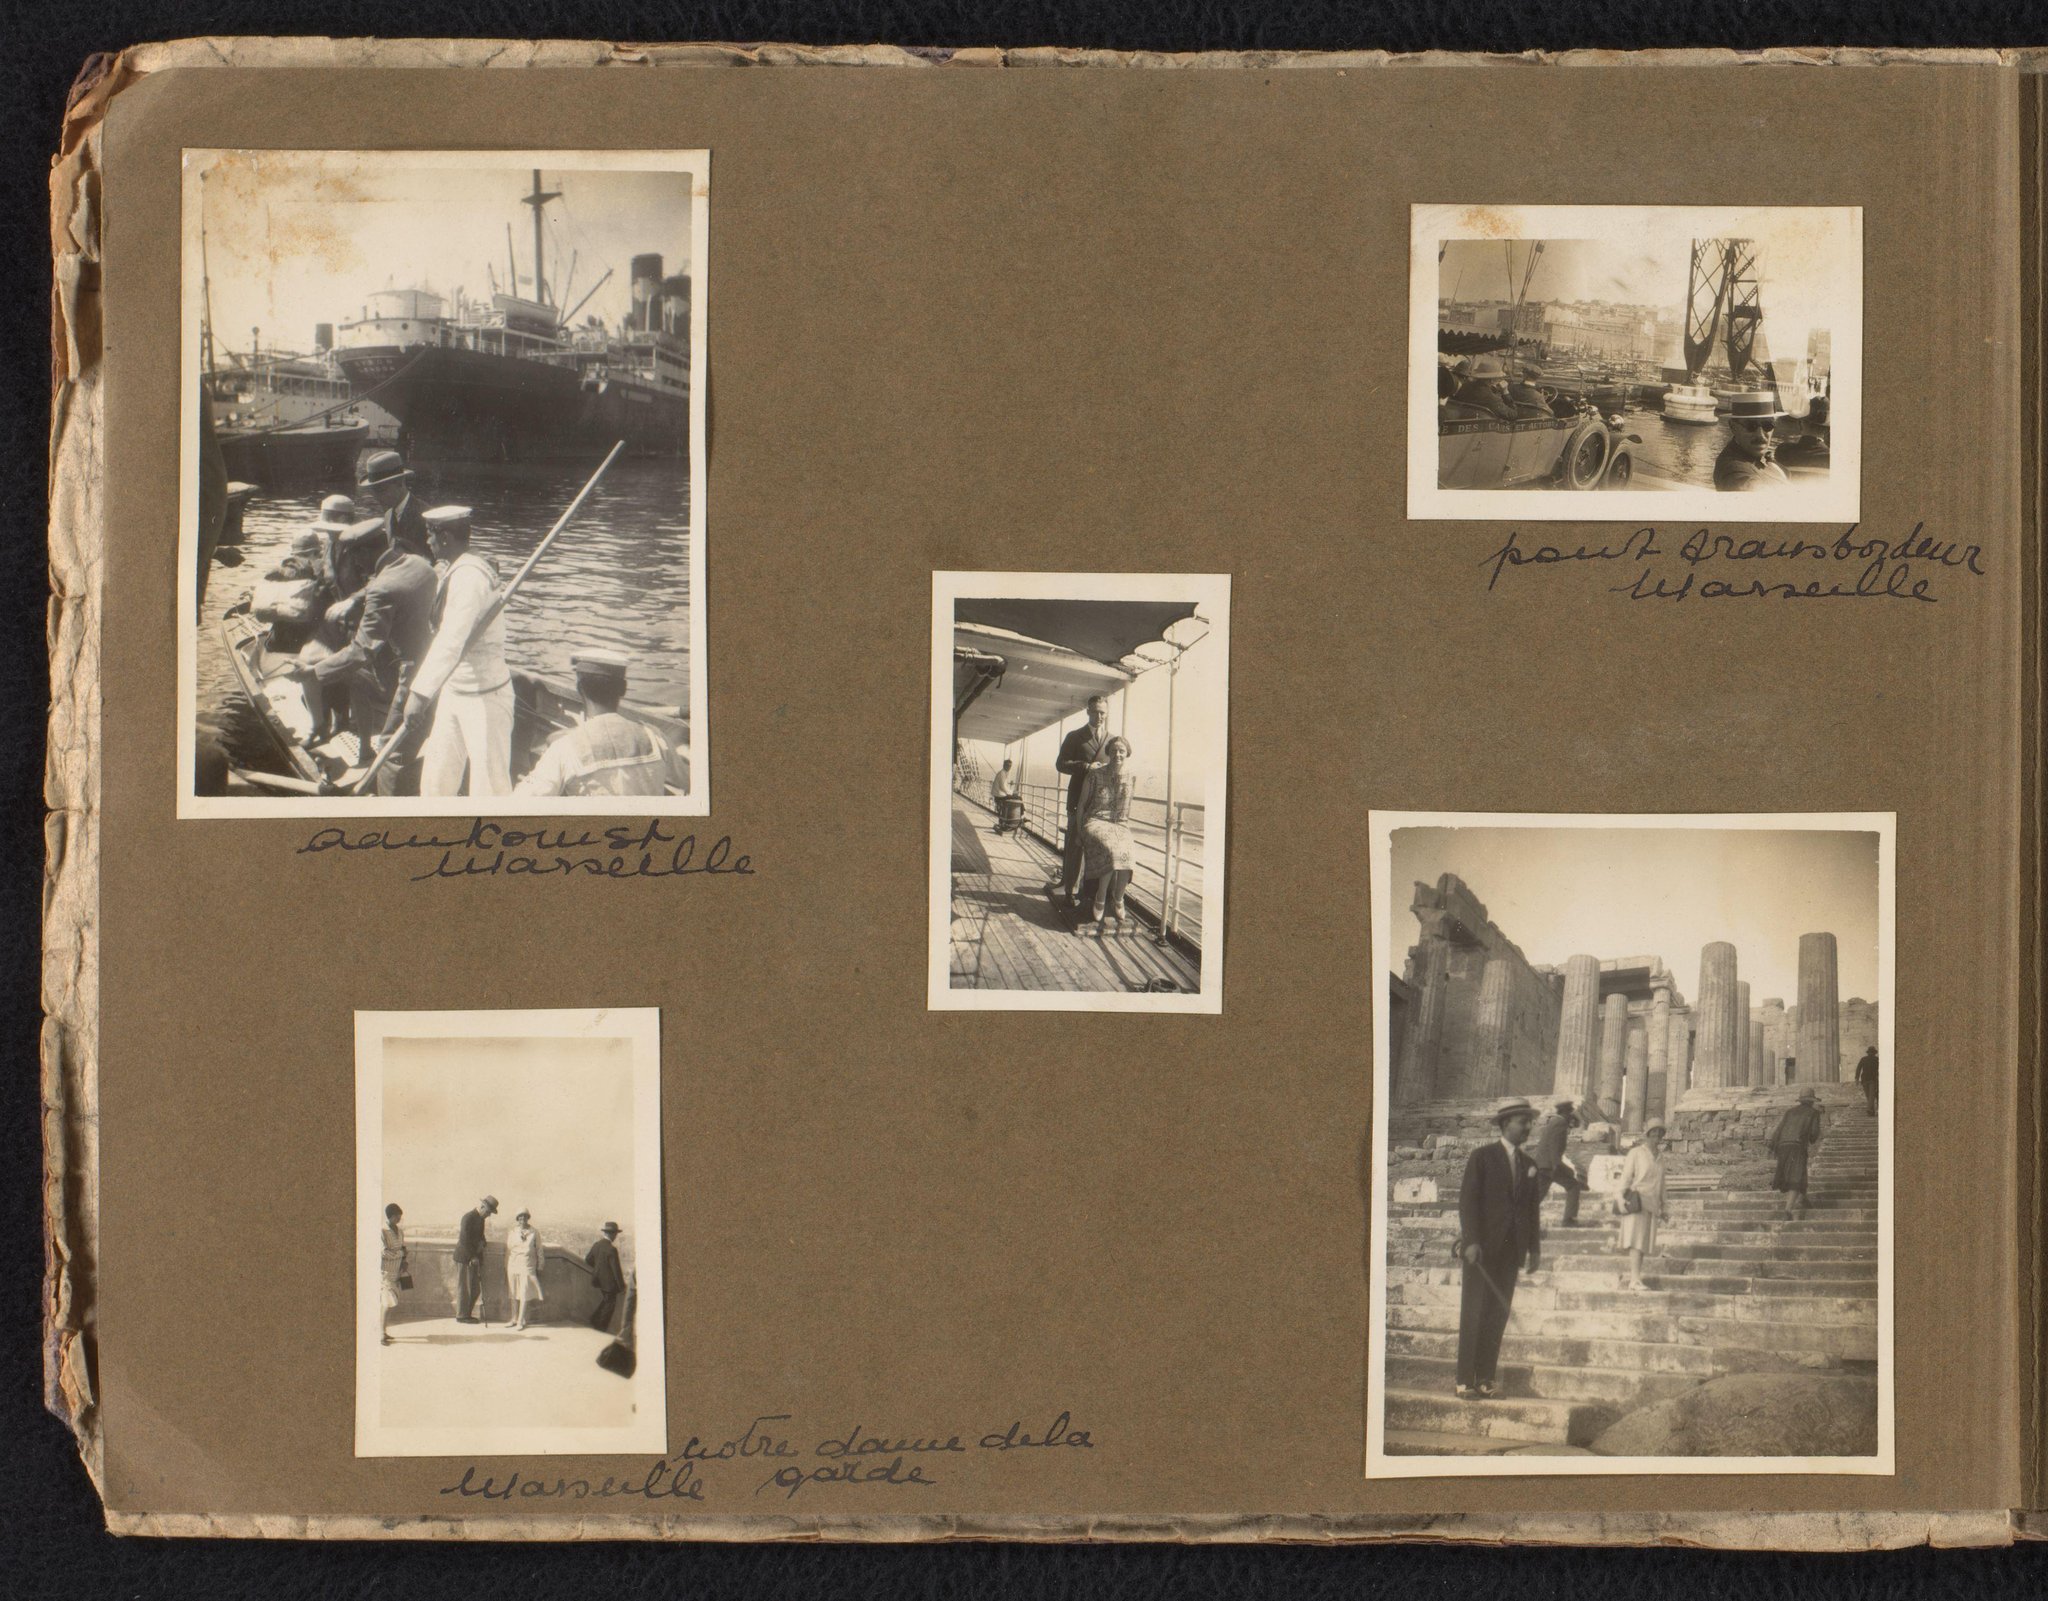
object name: album leaf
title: Vijf foto's van een reis naar Marseille en Griekenland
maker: carolina frederika onnen (lien/loen)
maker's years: 1896-1983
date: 1909-1926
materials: paper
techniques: gelatin silver print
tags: harbour, ruin of a building ~ architecture, passengers ~ ship, marseille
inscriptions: inscription: ‘pont transbordeur/ Marseille’, inscription: ‘notre dame dela/ garde/ Marseille’, inscription: ‘aankomst/ Marseille’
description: Deze foto's maken deel uit van een album.